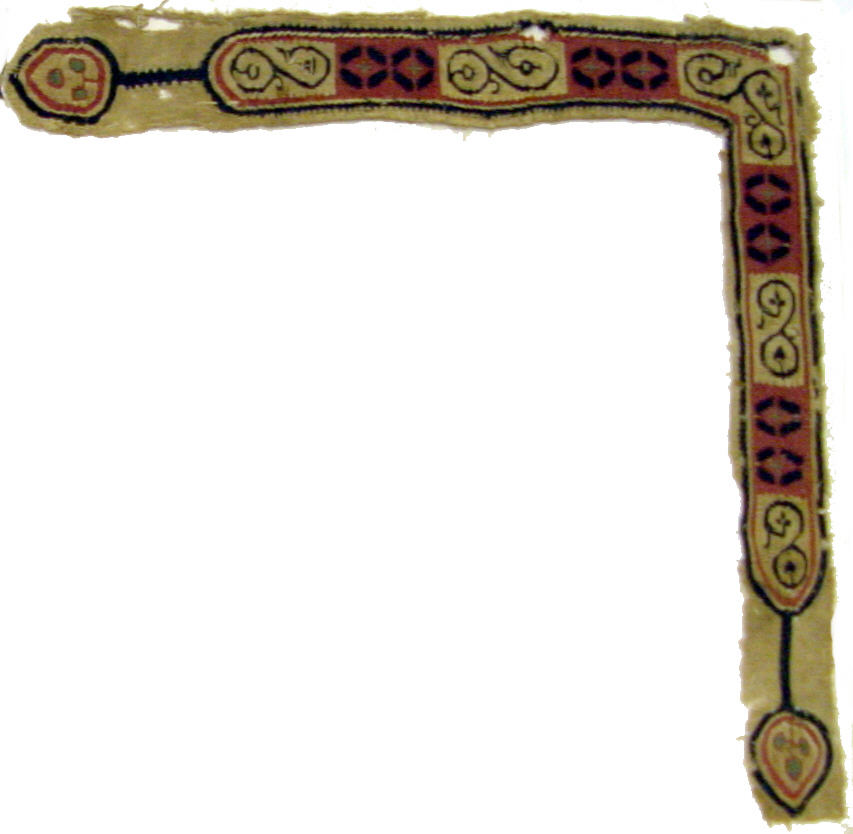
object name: textile fragment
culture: coptic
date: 501-600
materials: linen, wool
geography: egypt